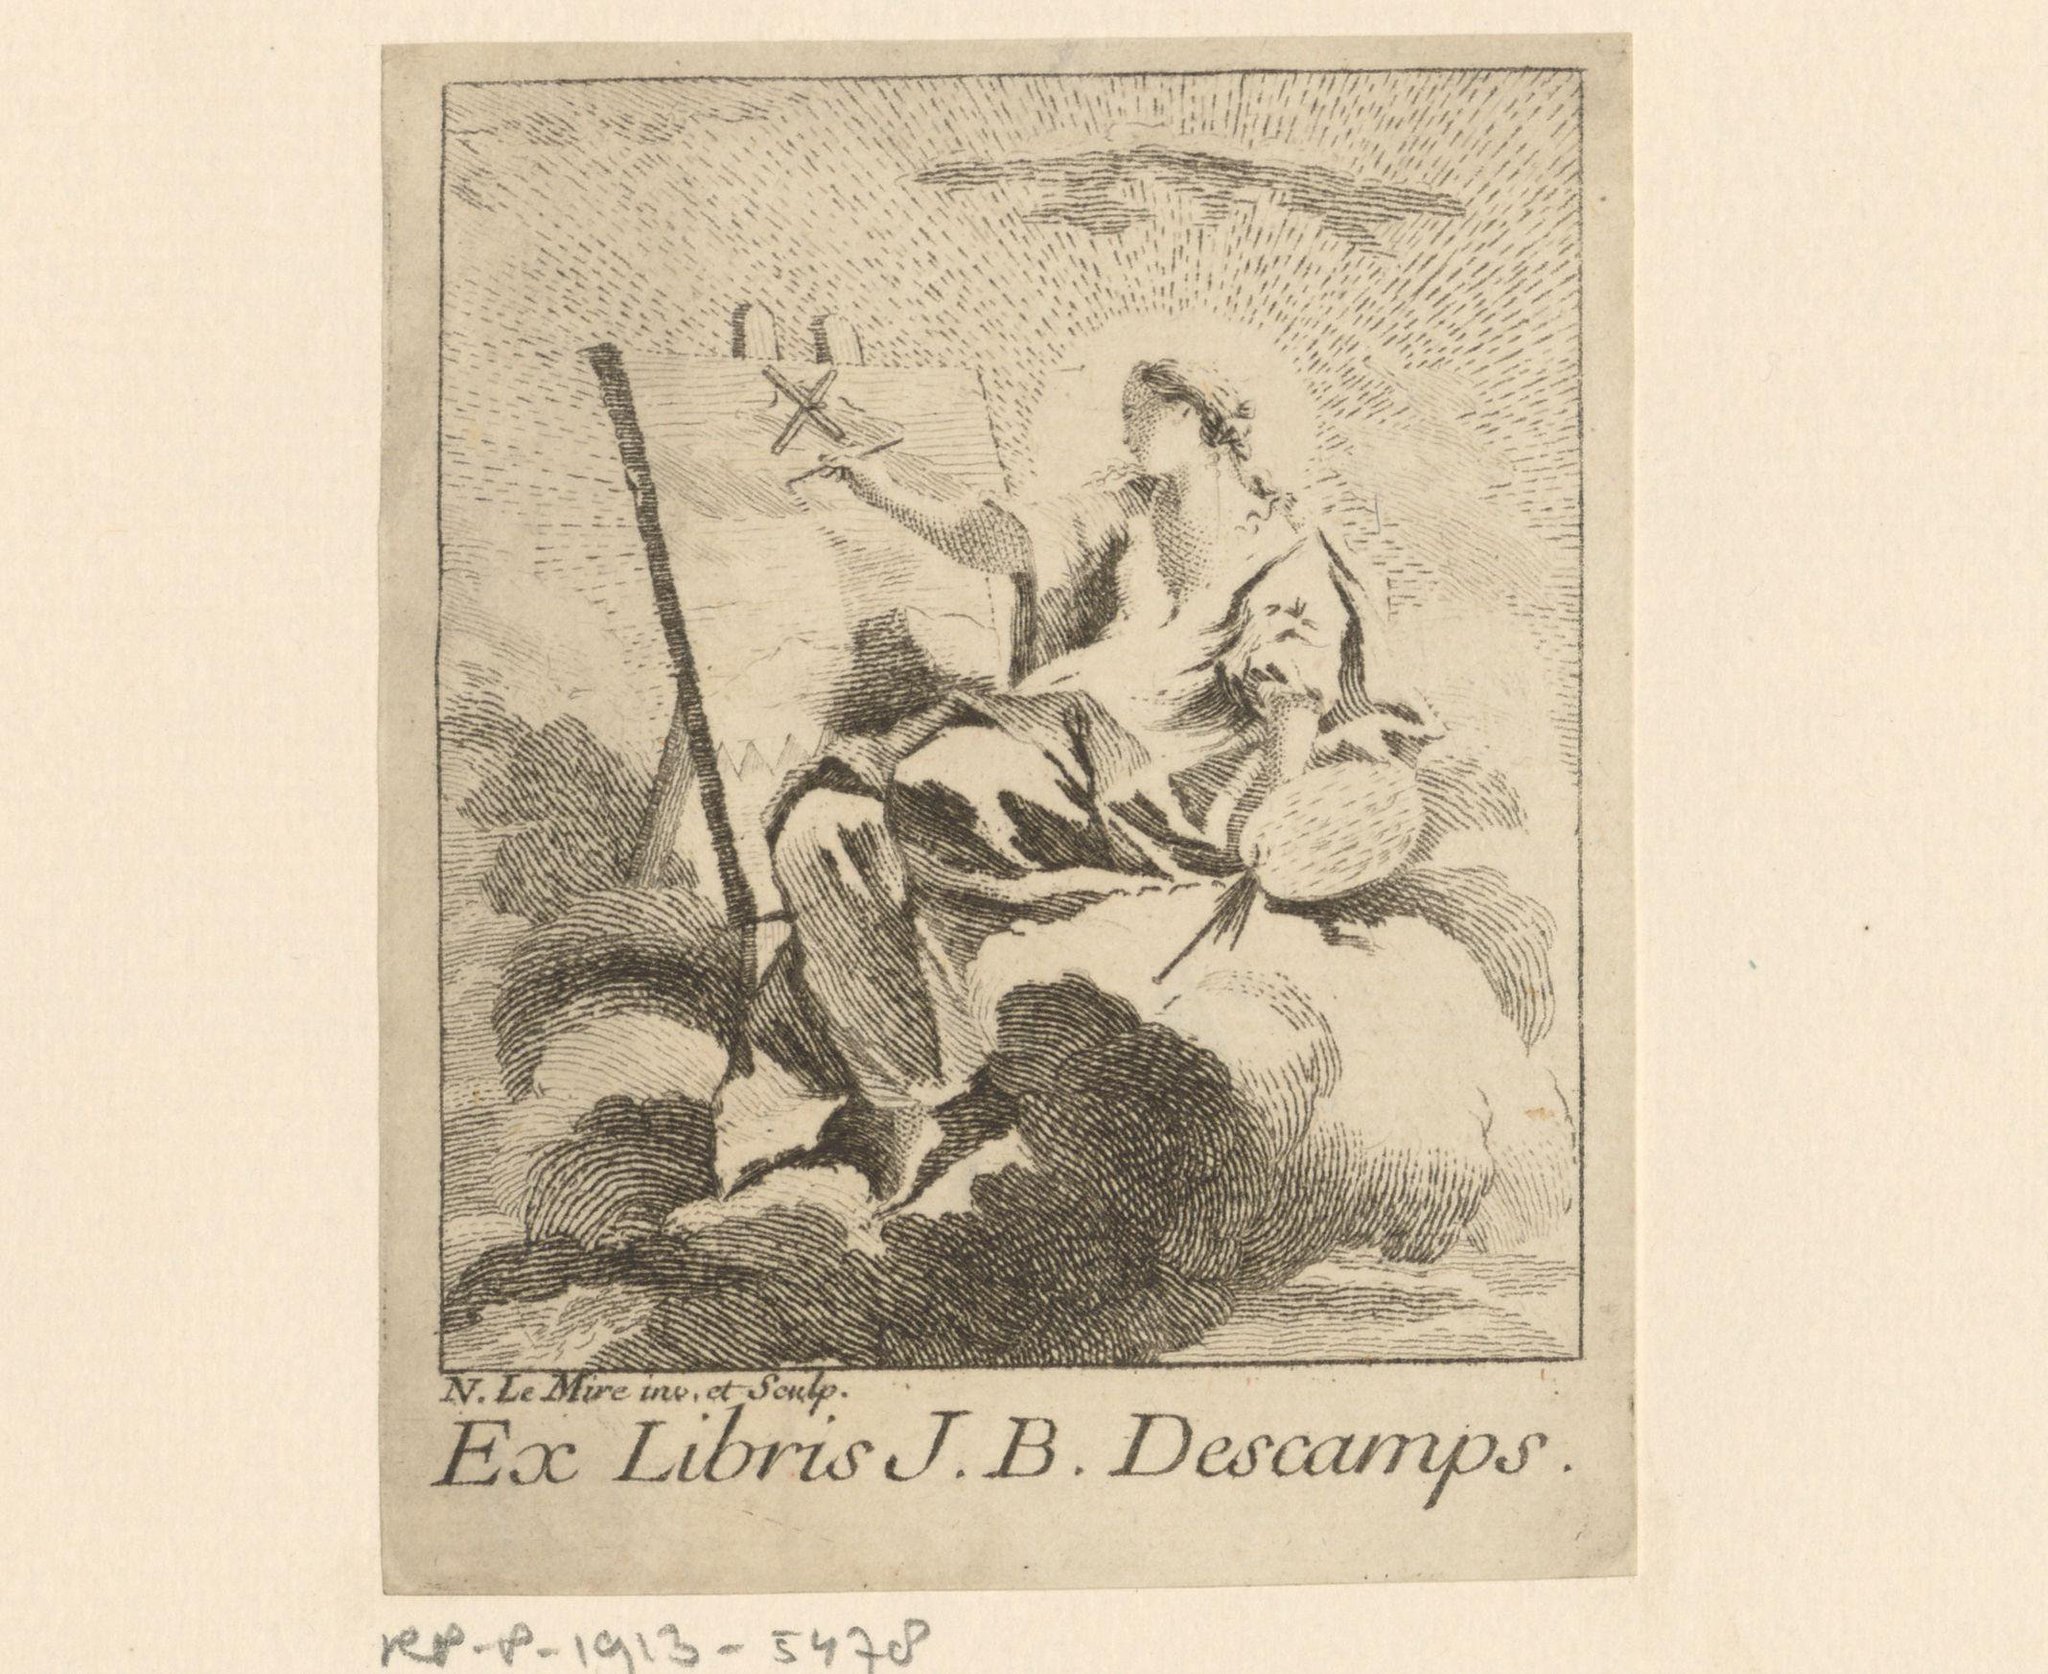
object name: bookplate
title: Ex libris van Jean-Baptiste Descamps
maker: noël le mire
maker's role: print maker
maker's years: 1724-1801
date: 1734-1791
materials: paper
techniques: etching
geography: france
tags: painter, draughtsman, jean baptiste descamps, sitting figure - aa - female human figure, 'pictura', symbolic representations, allegories and emblems ~ painting; 'pittura' (ripa), painting (including book-illumination, miniature-painting)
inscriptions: collector's mark: Lugt 2233, collector's mark: Lugt 2760